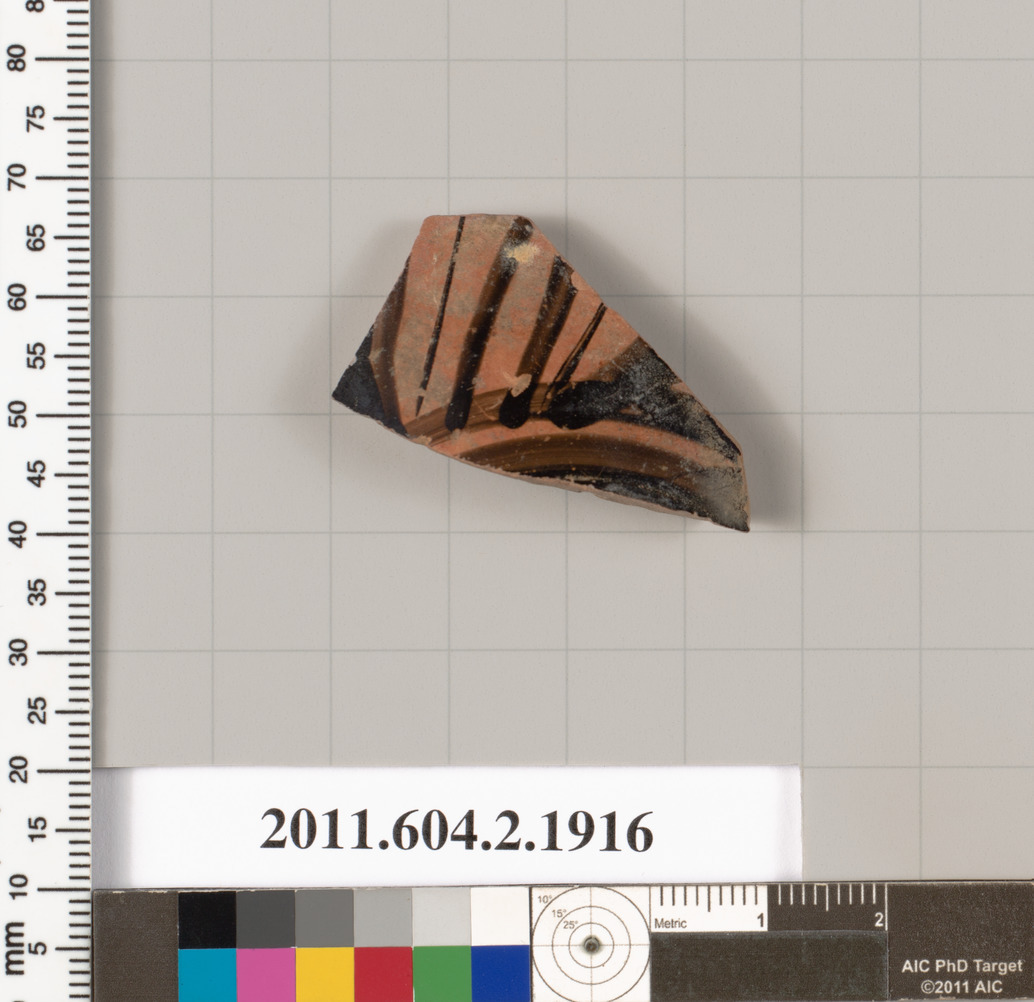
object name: skyphos fragment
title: Terracotta fragment of a skyphos (deep drinking cup)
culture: greek, attic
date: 460-430 BCE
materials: terracotta